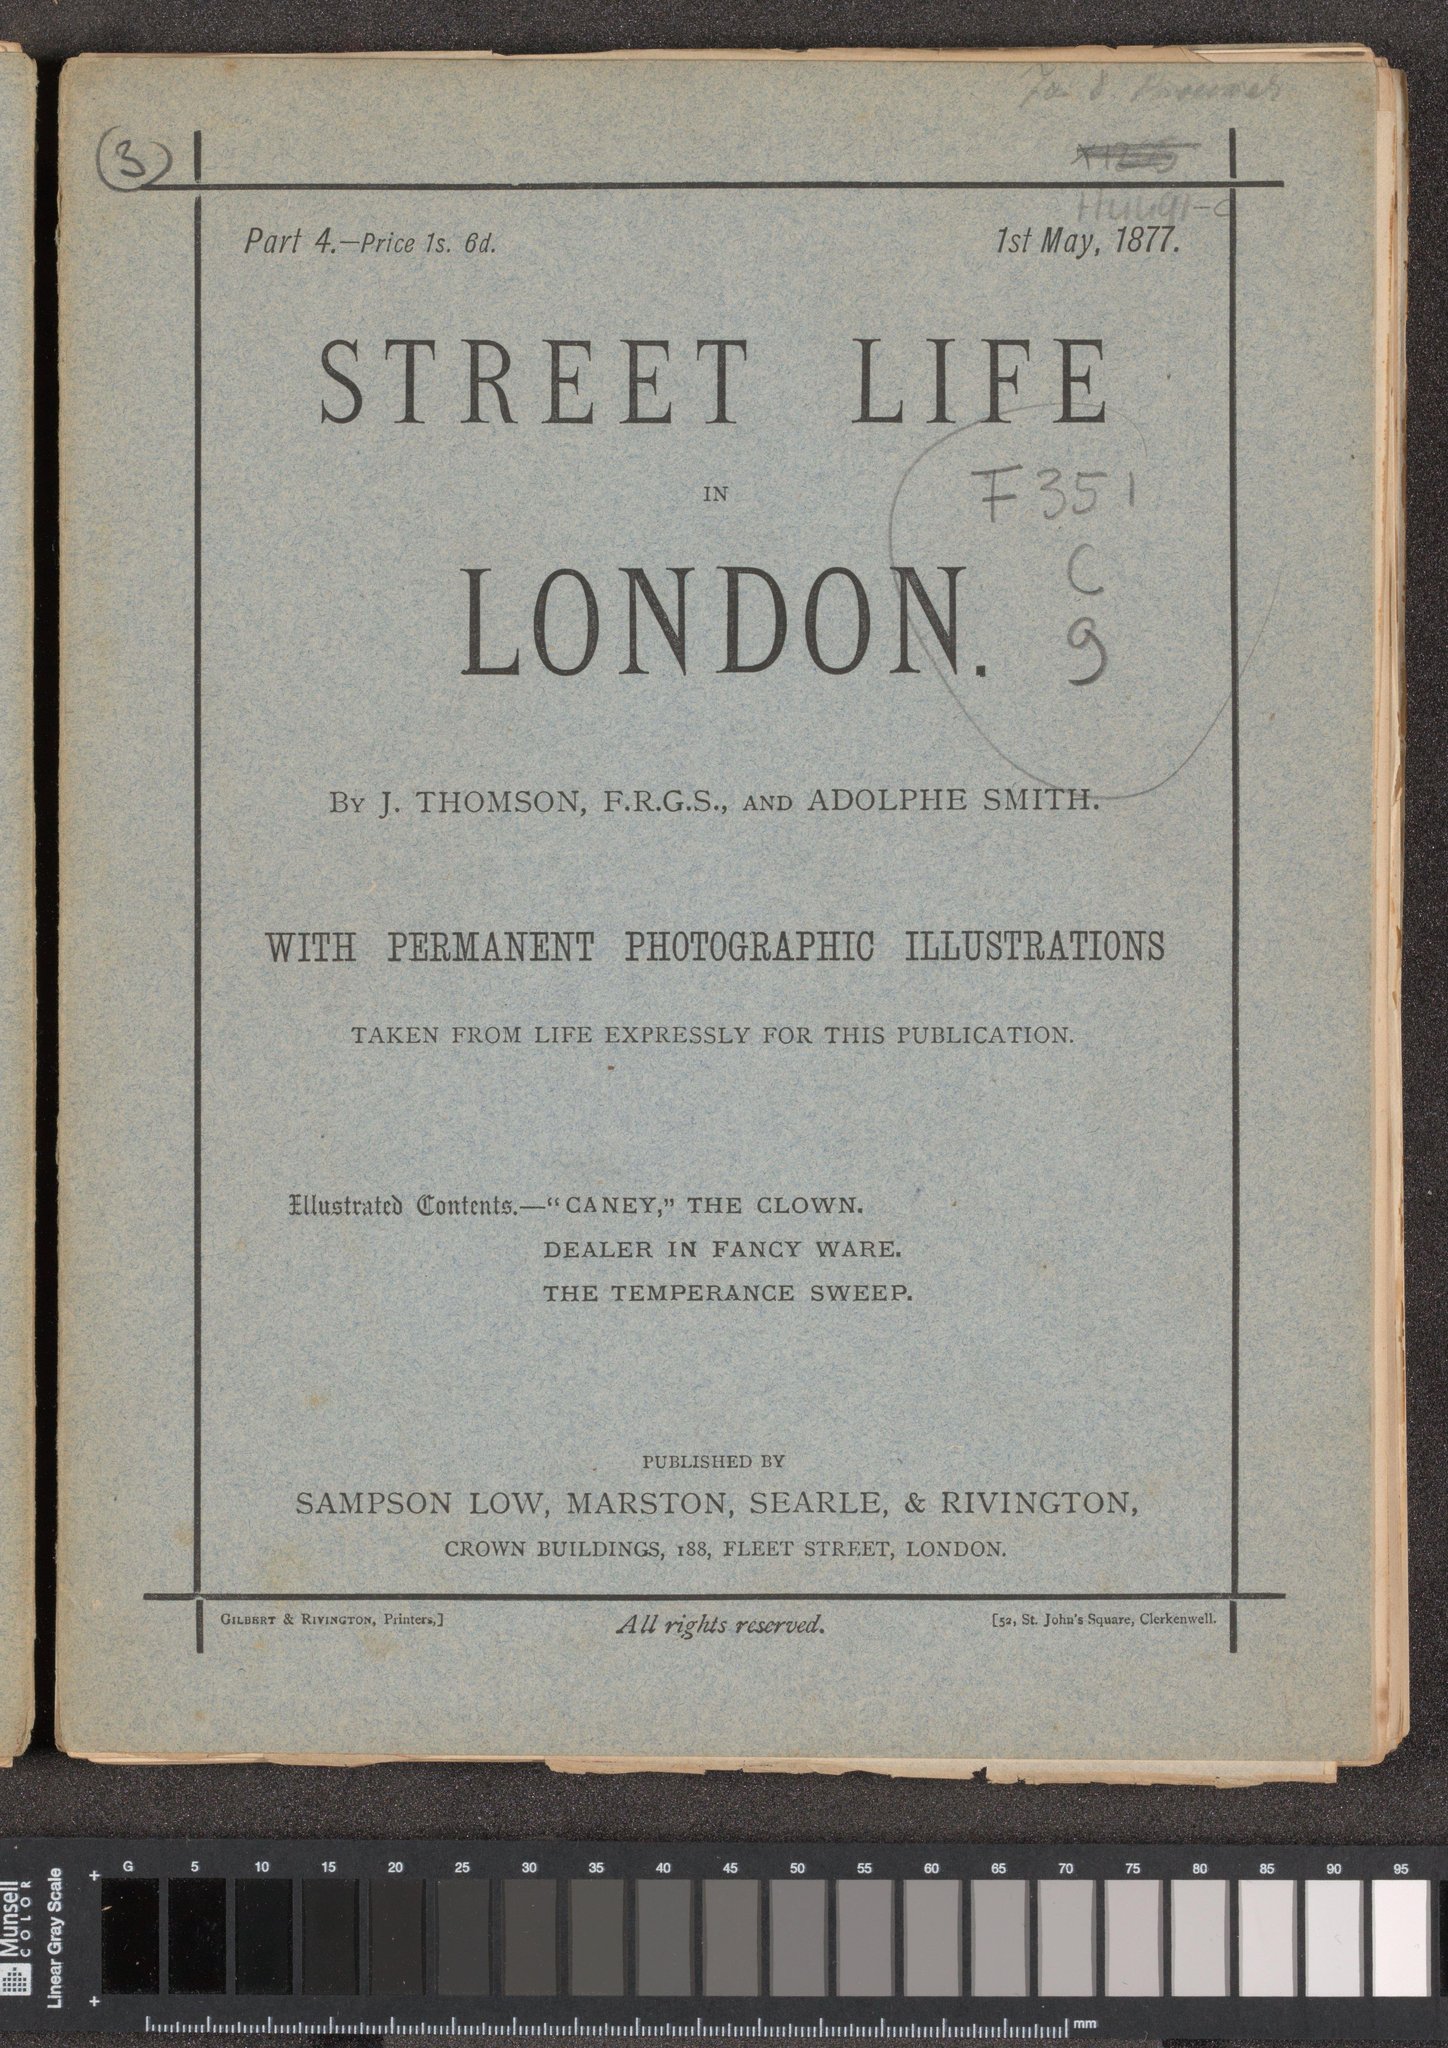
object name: magazine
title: Street life in London, Part 4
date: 1805-1877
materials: paper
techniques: etching, printing, woodburytype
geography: london